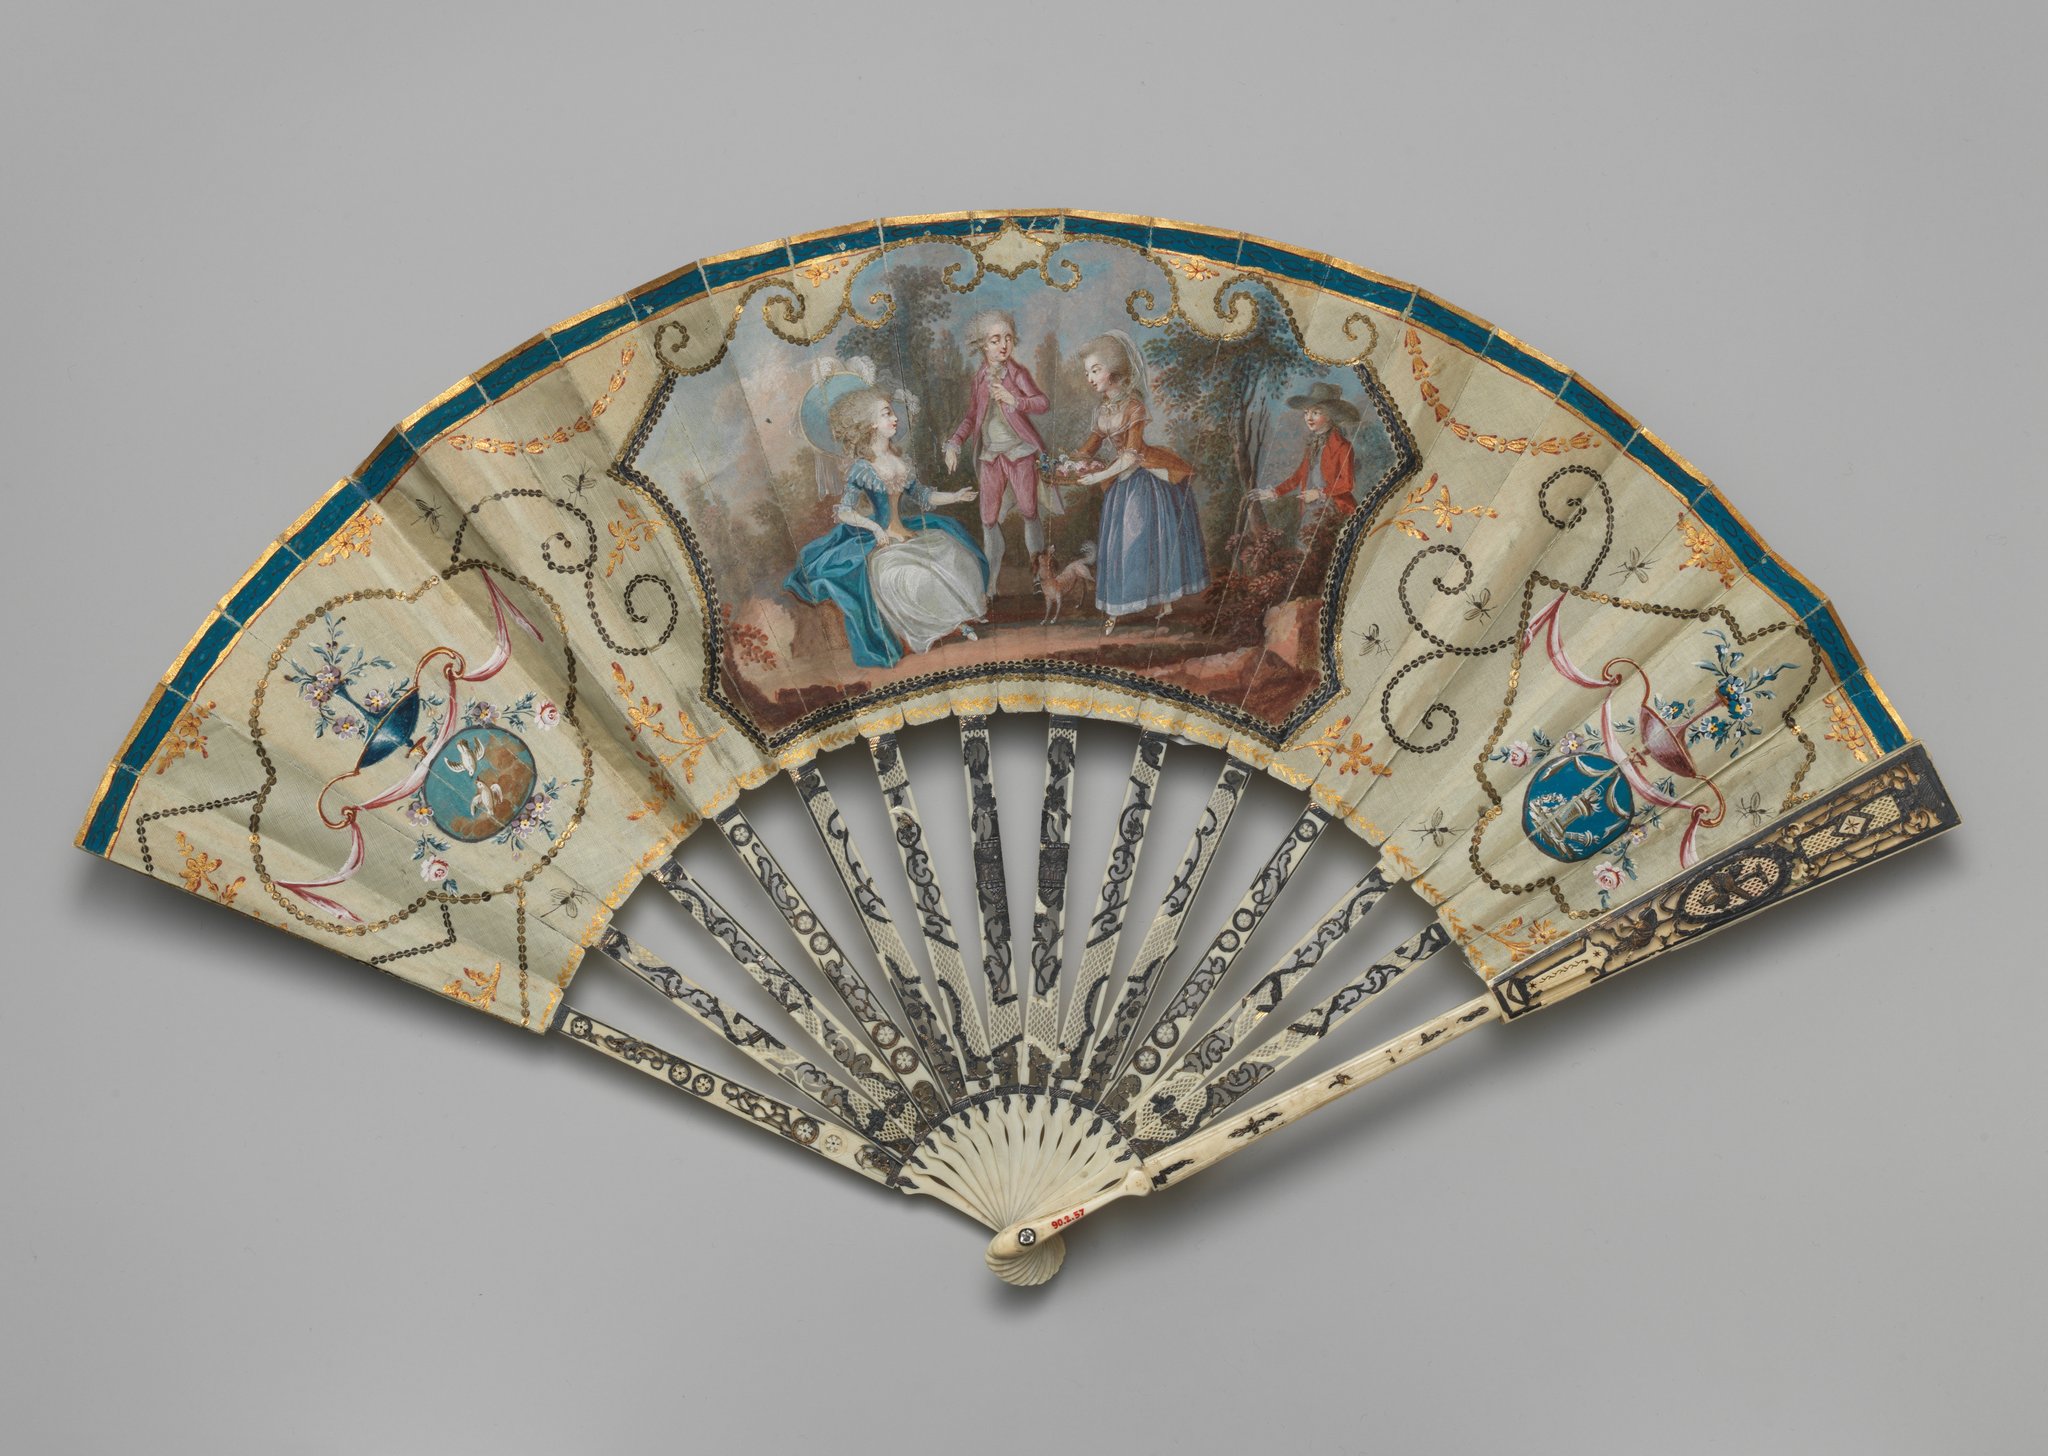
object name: fan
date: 1785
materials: ivory, silk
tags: men,women,dogs,flowers